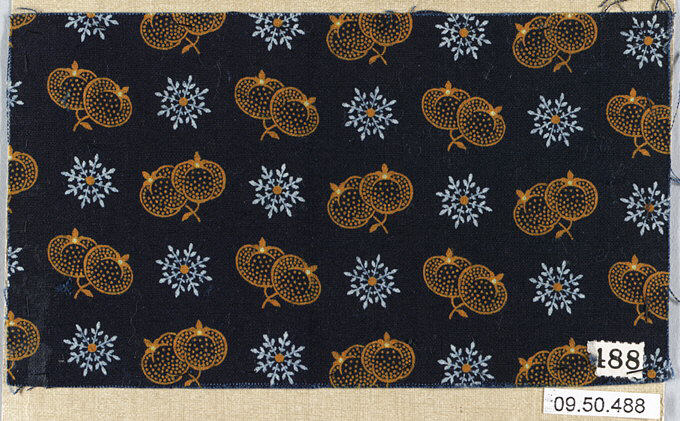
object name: piece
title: Piece (one of 13)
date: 1801-1900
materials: cotton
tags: leaves